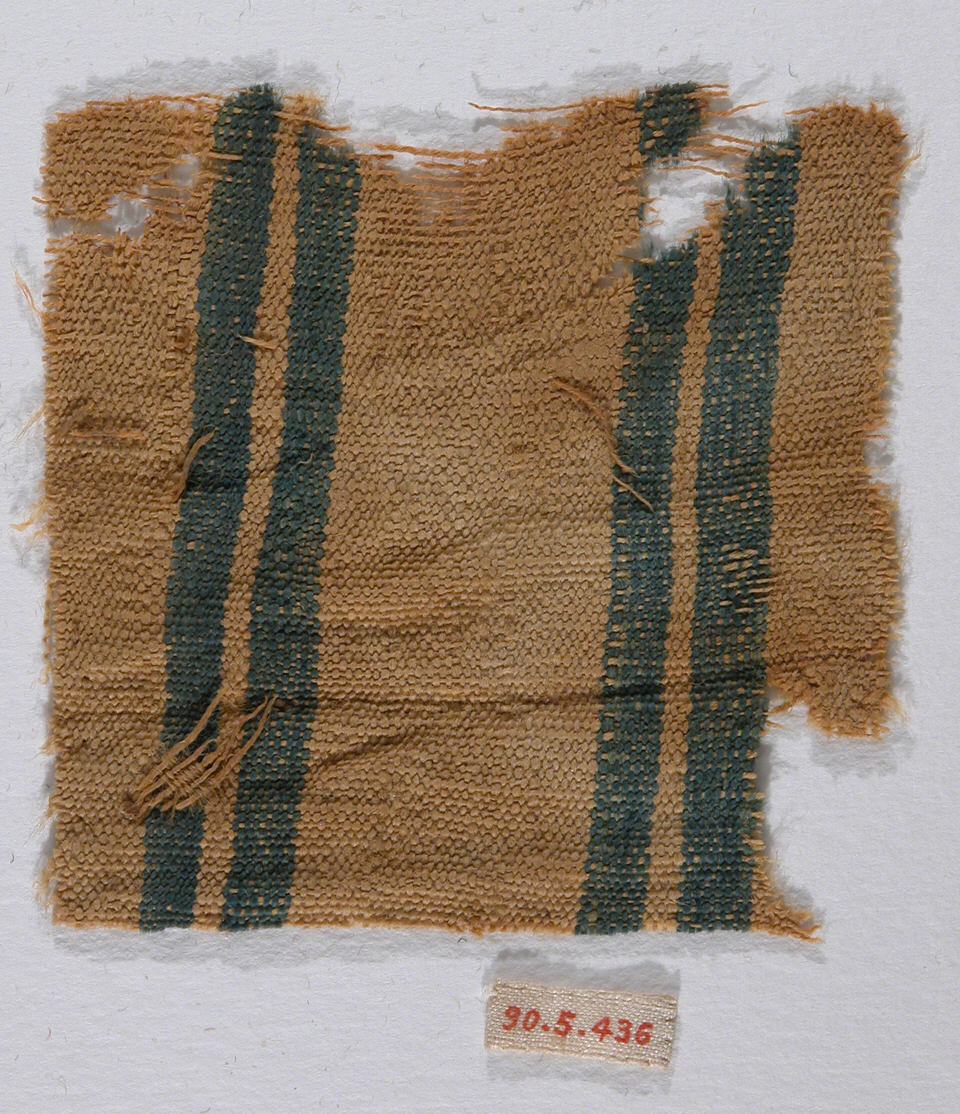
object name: textile fragment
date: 201-400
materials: linen, wool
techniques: weave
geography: egypt